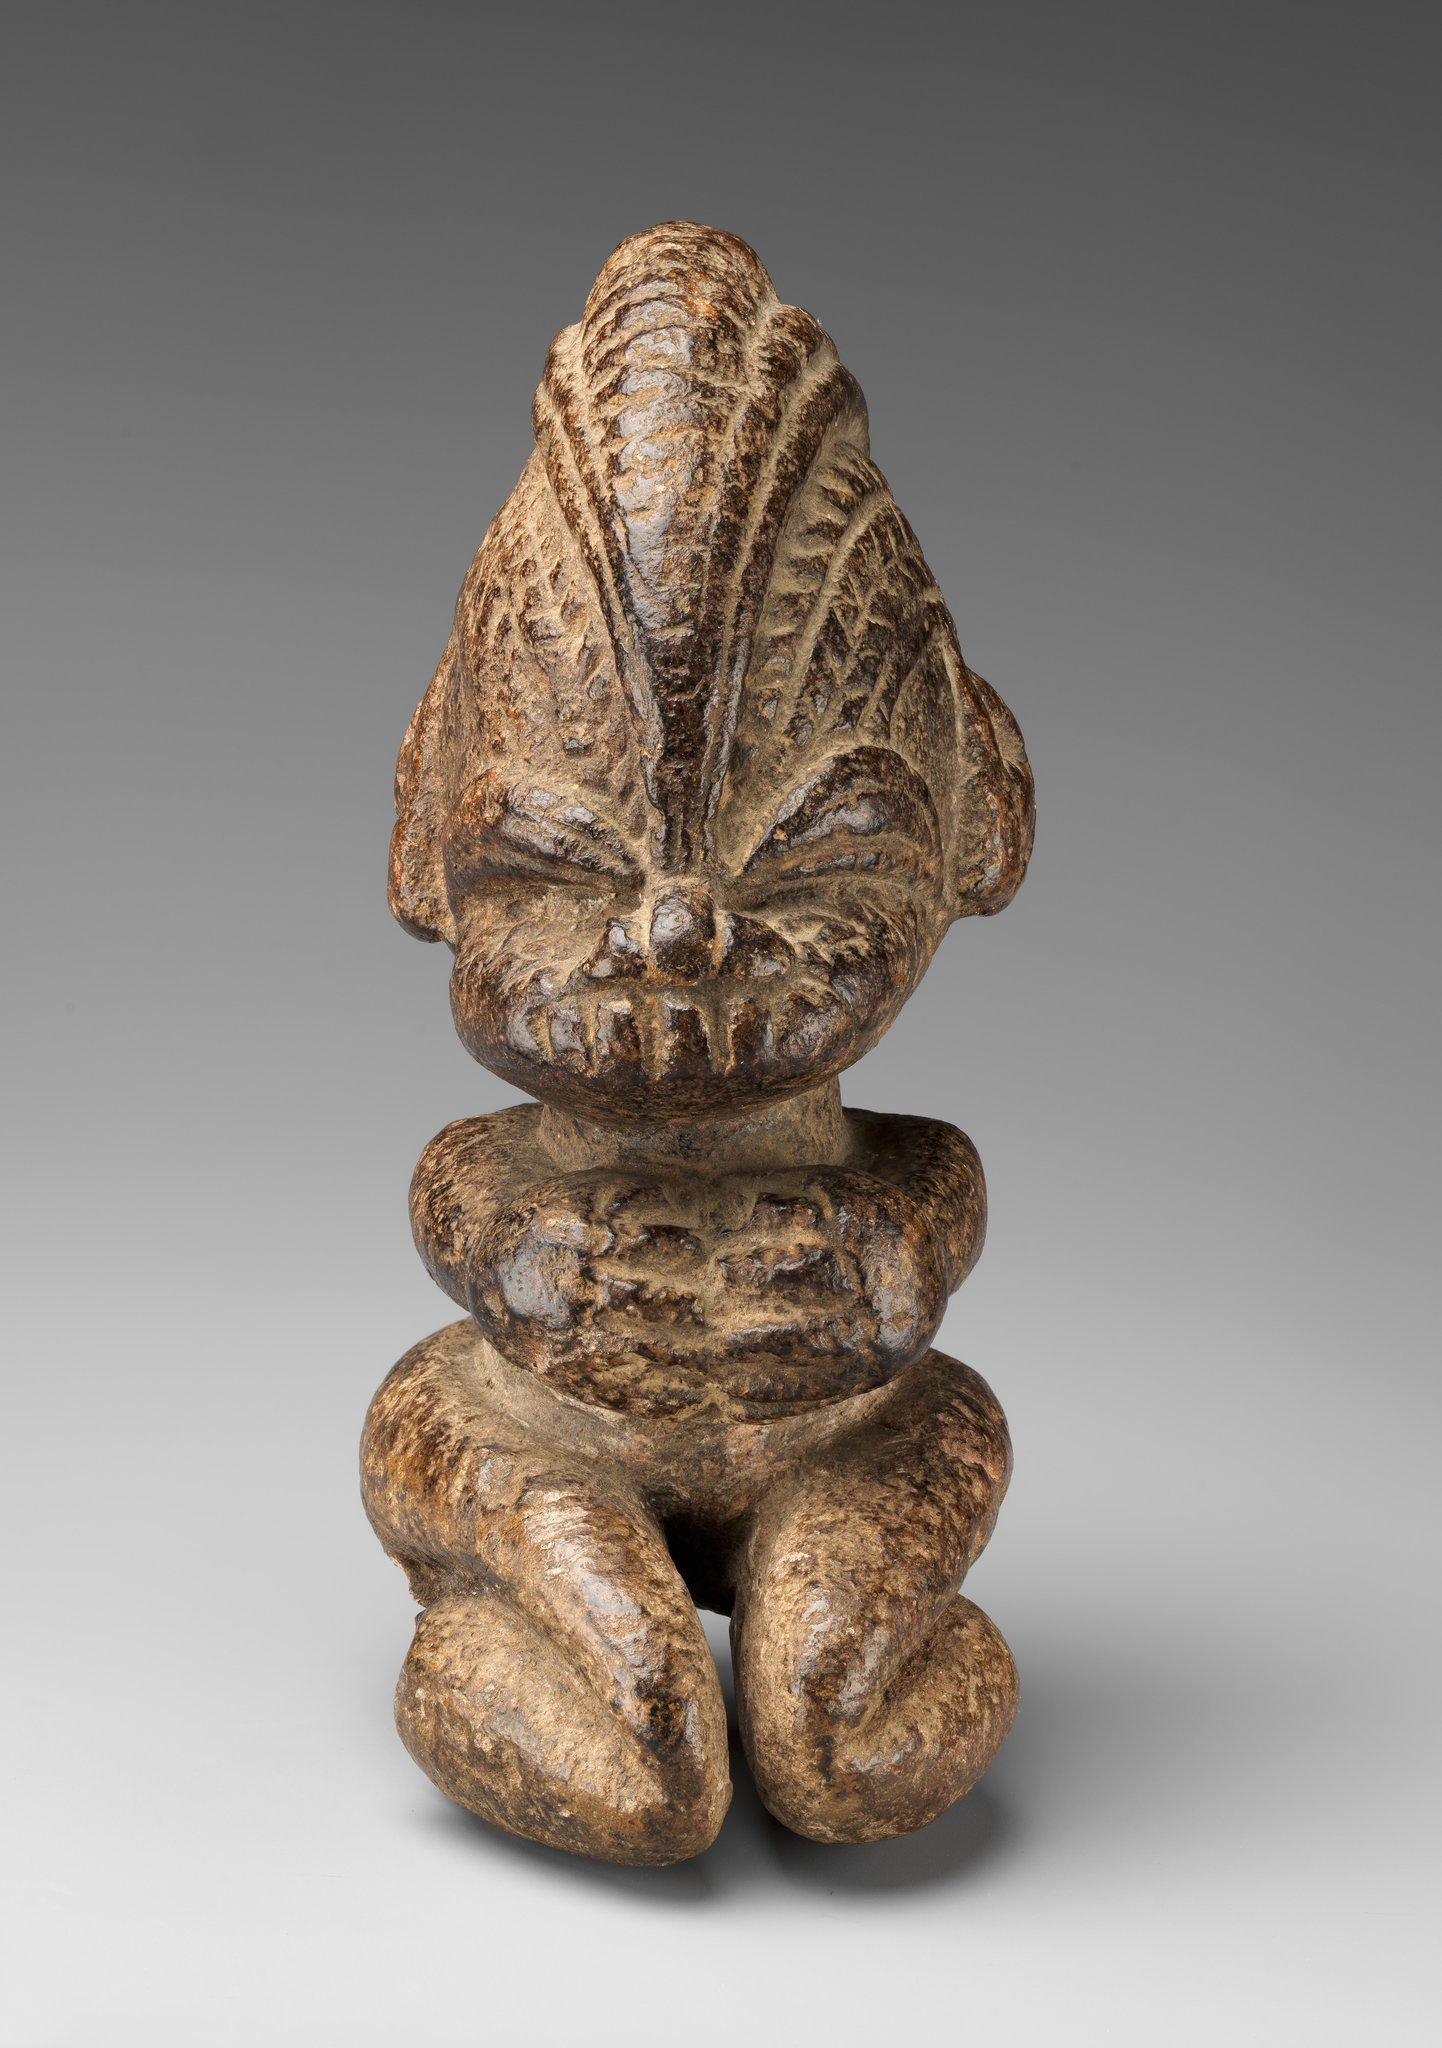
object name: figure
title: Seated Figure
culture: bullom or temne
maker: temne or bullom artist(s)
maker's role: artist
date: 1501-1600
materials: stone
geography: sierra leone